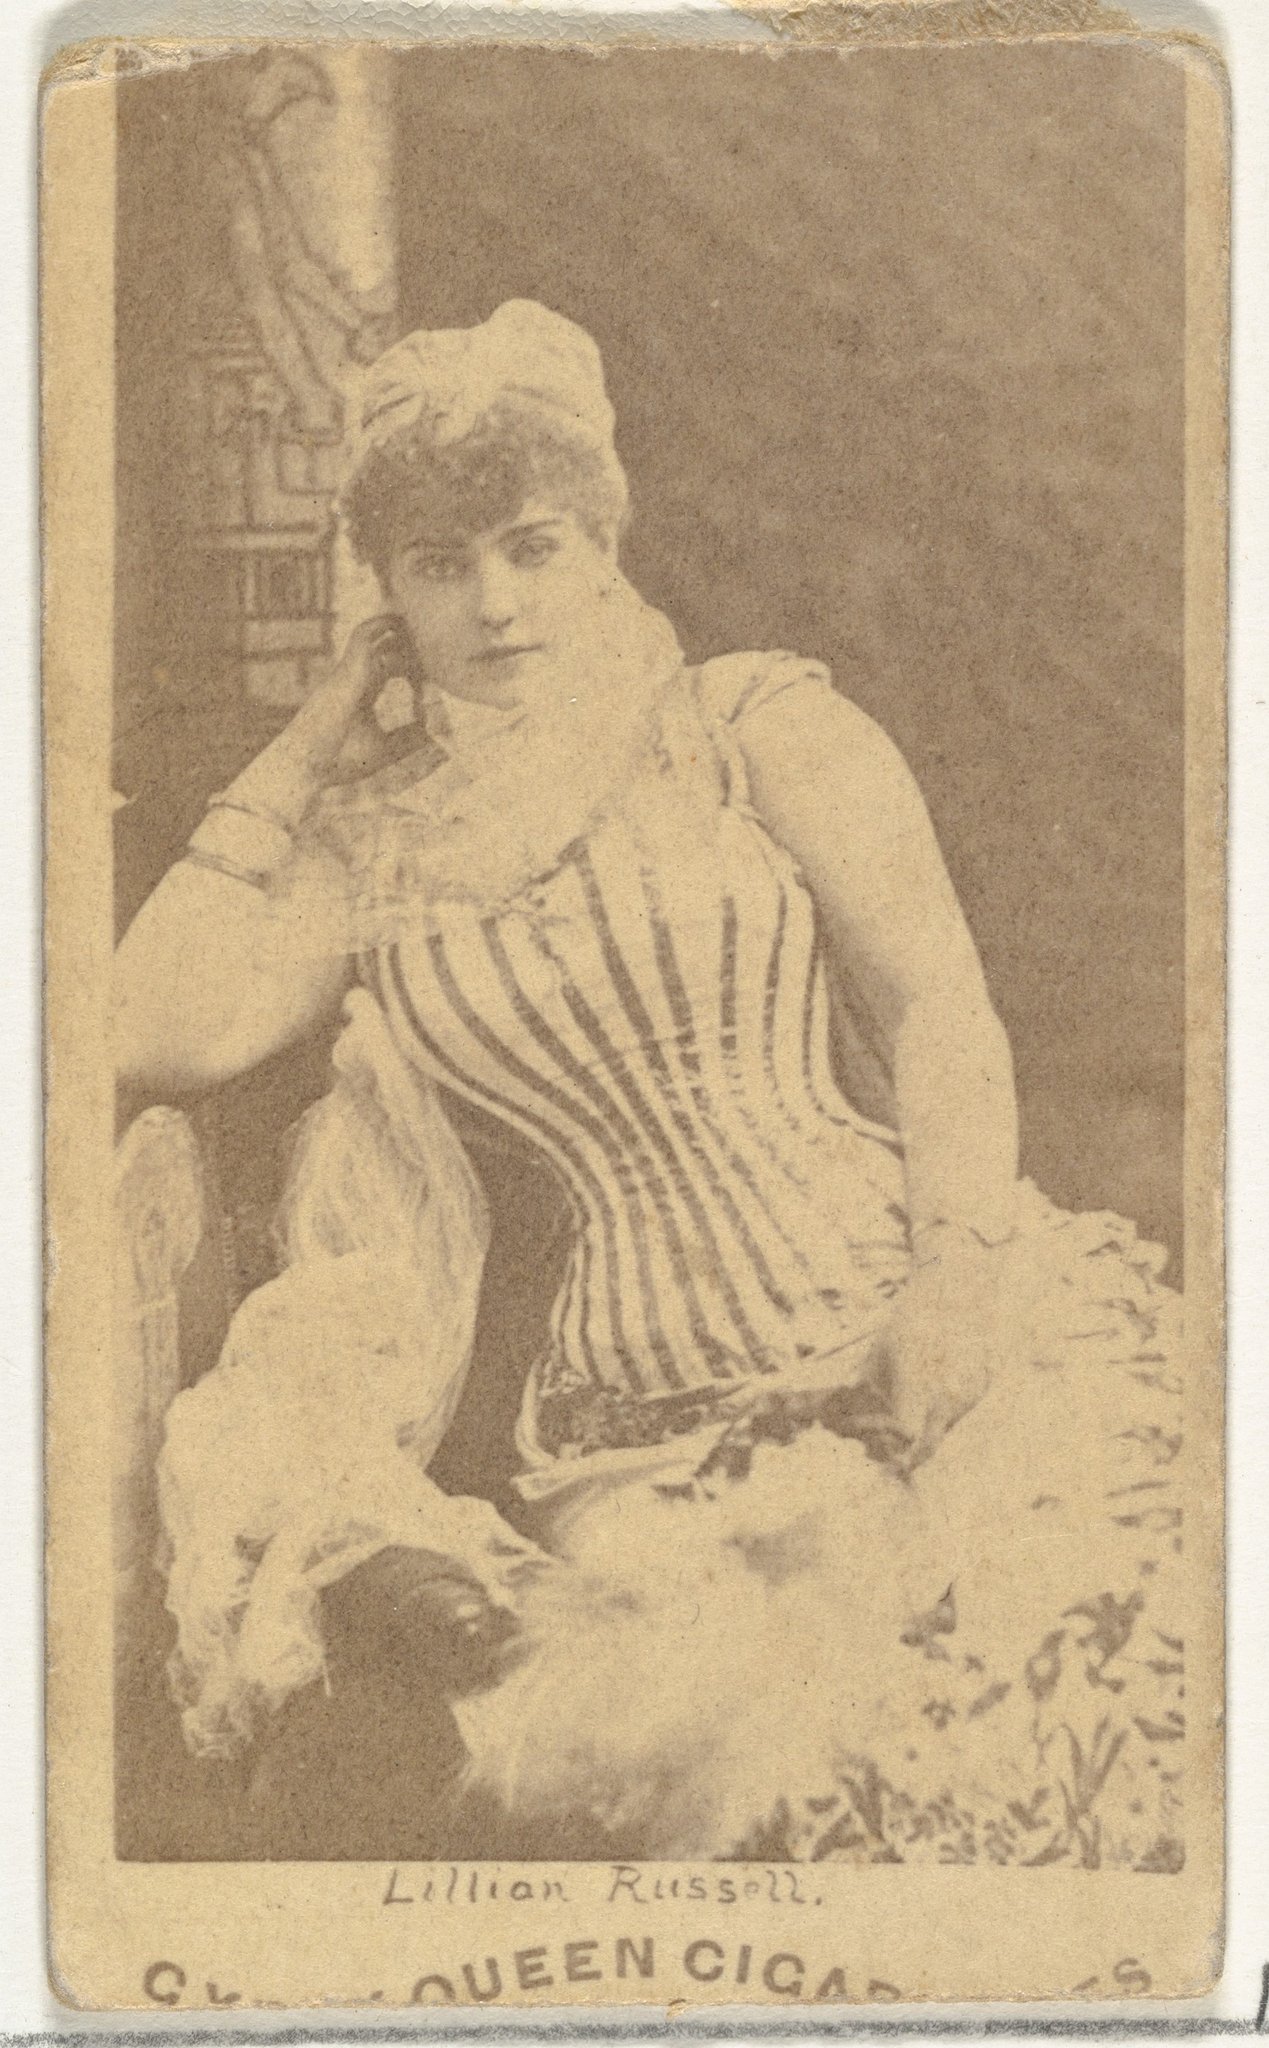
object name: photograph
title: Lillian Russell, from the Actors and Actresses series (N171) for Gypsy Queen Cigarettes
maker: goodwin & company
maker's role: publisher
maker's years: 1850-1950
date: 1886-1890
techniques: albumen silver print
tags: portraits,women,actresses